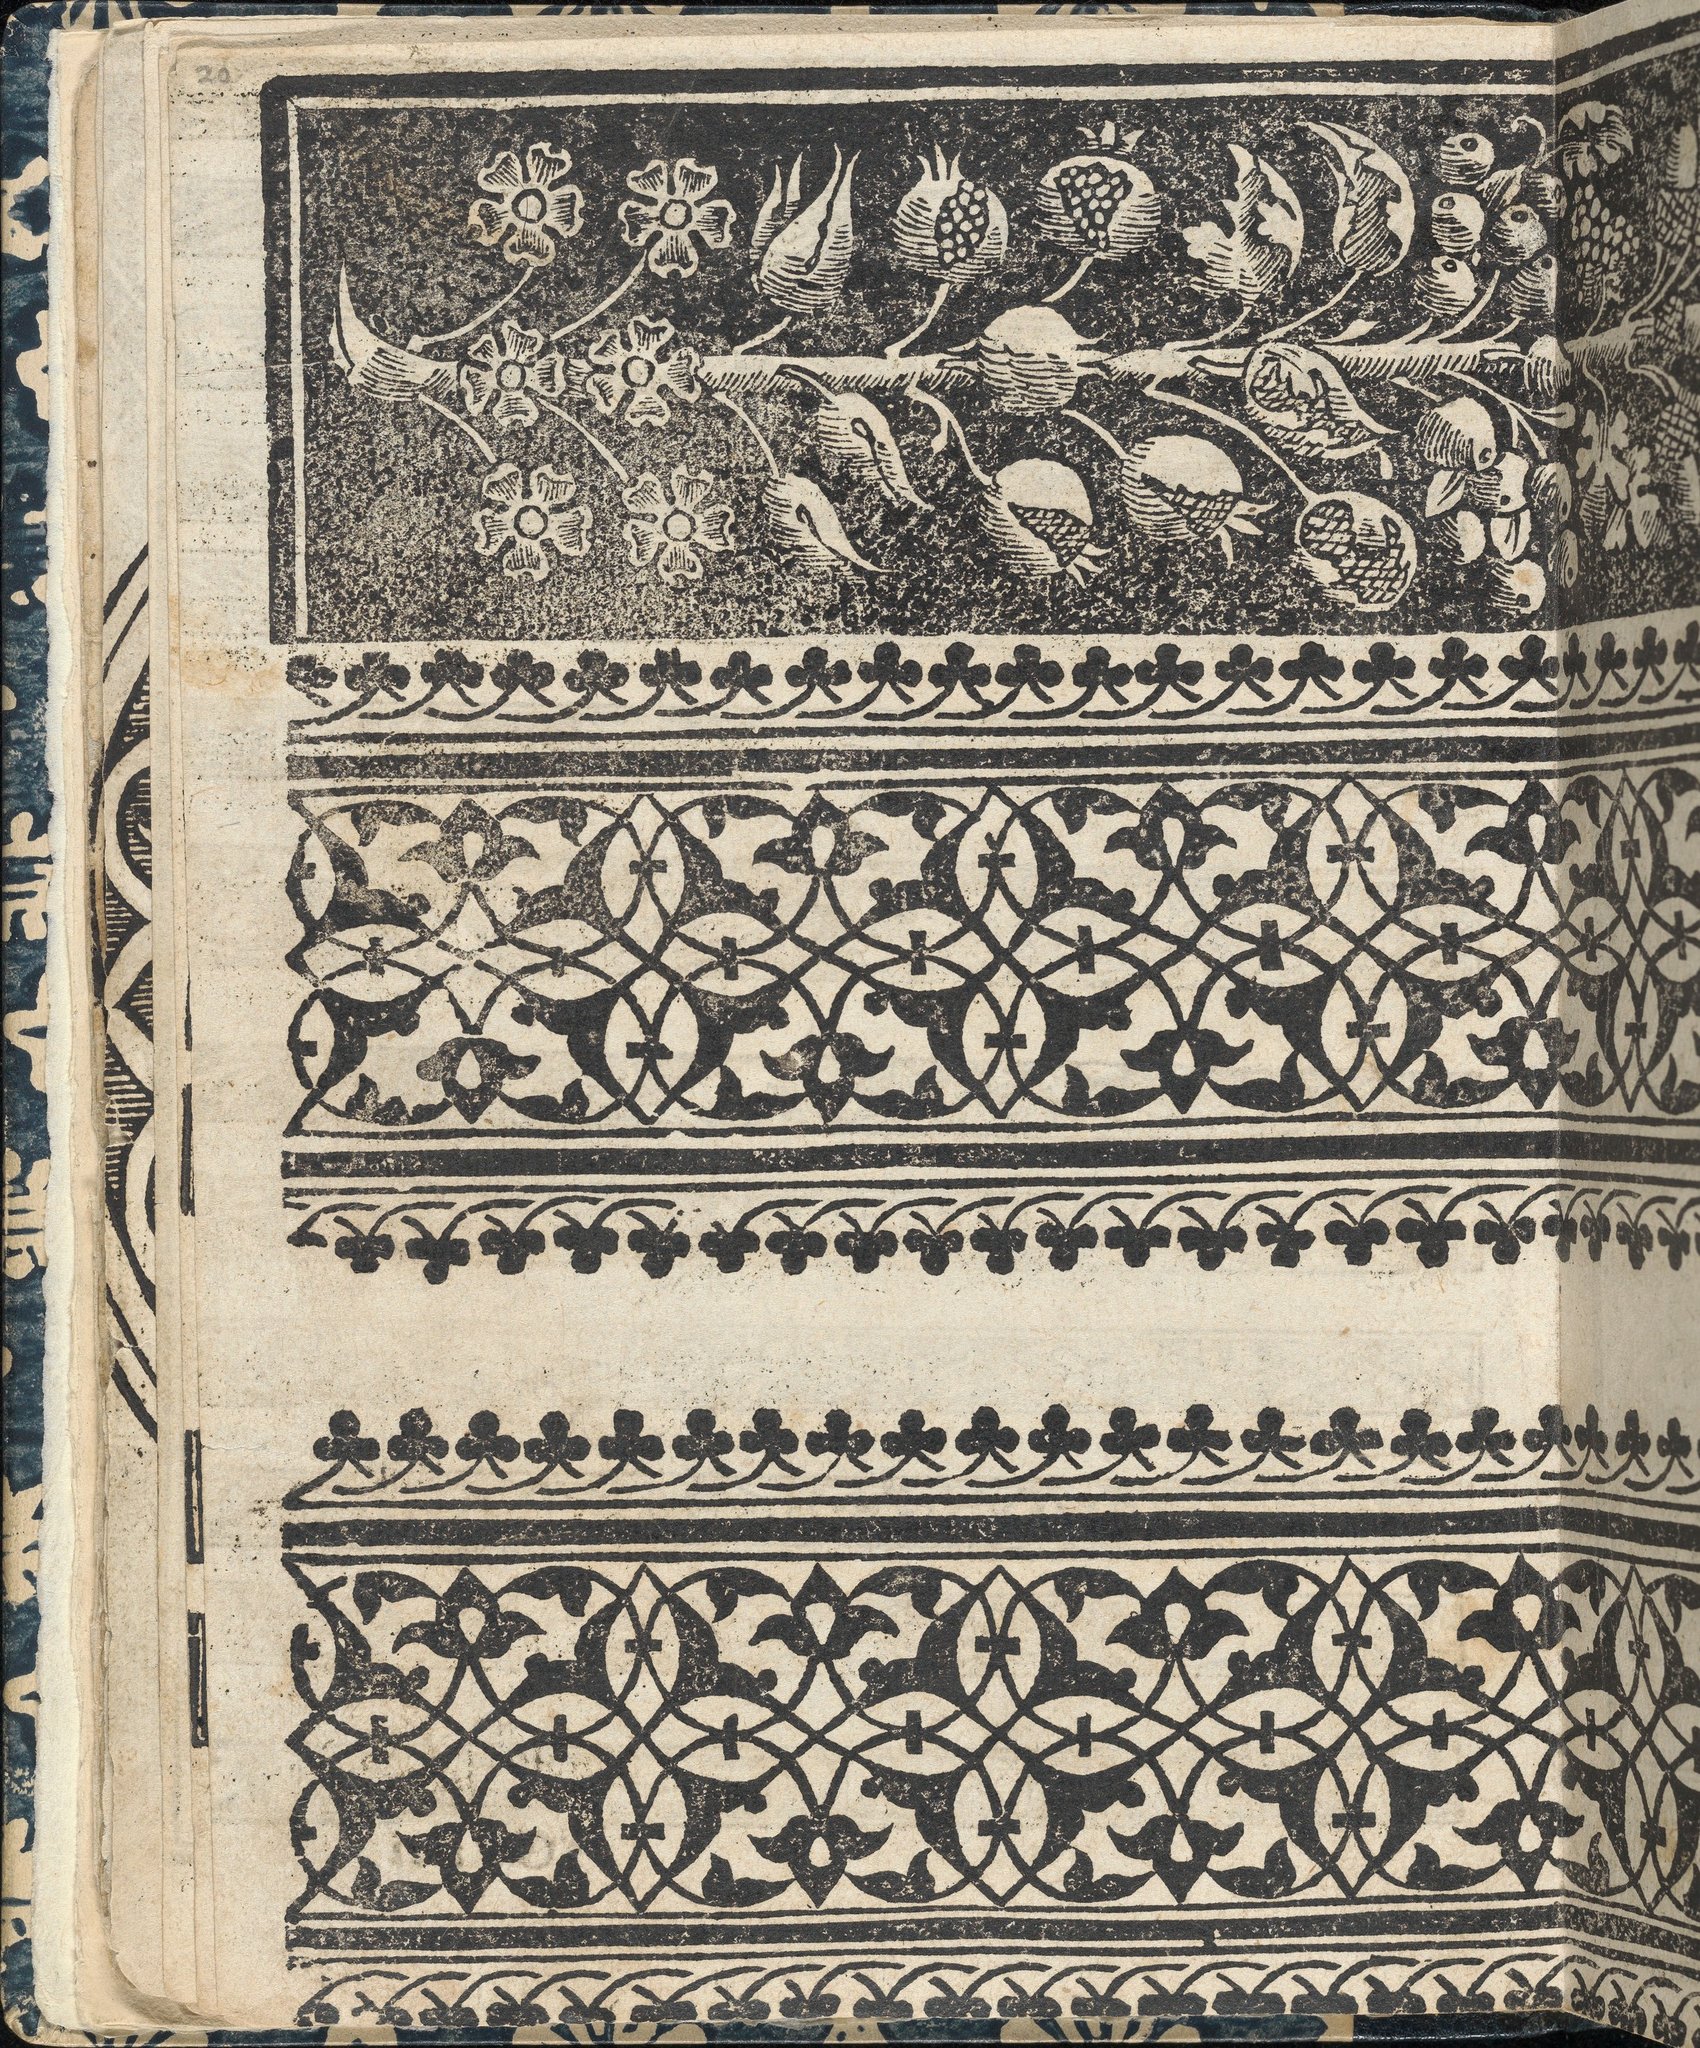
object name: book print ornament architecture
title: Essempio di recammi, page 20 (verso)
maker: giovanni antonio tagliente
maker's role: author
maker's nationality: italian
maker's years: 1465-1528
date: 1530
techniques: woodcut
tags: fruit,flowers,acorns